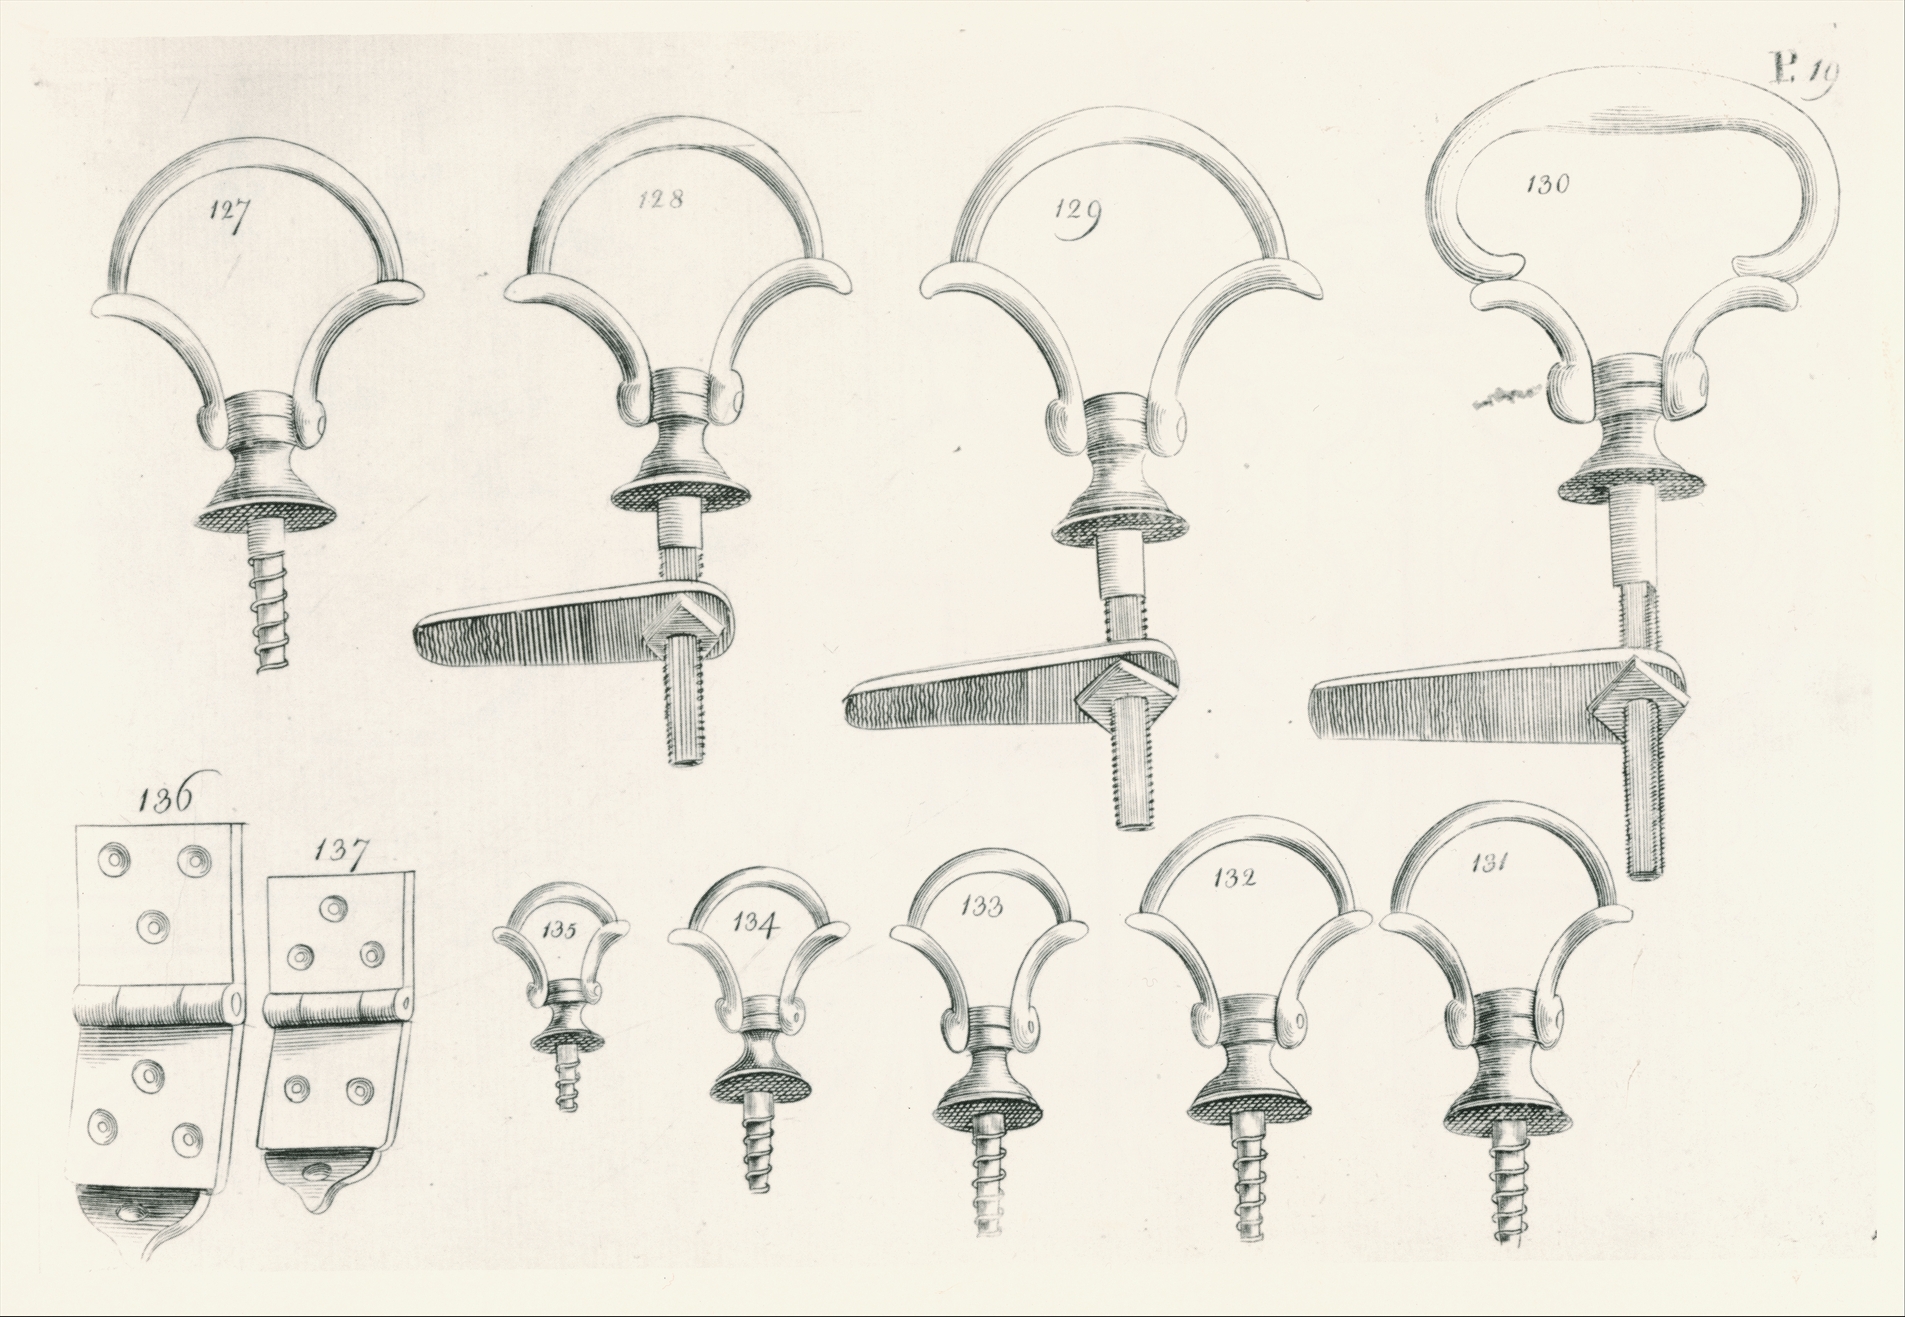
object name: book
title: Manufacturer's Catalogue of Hardware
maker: anonymous, british, 18th century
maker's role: artist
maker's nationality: british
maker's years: 1700-1800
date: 1701-1800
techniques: engraving